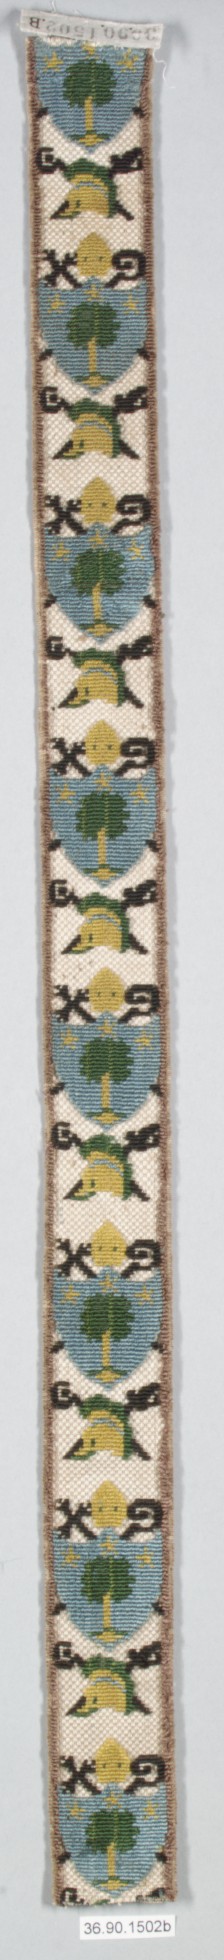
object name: galloon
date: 1701-1900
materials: silk